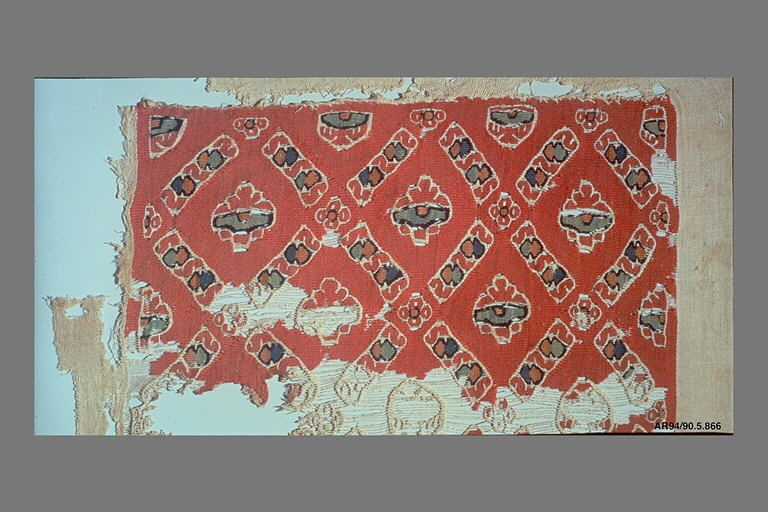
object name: textile fragment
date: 501-700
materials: linen, wool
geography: egypt